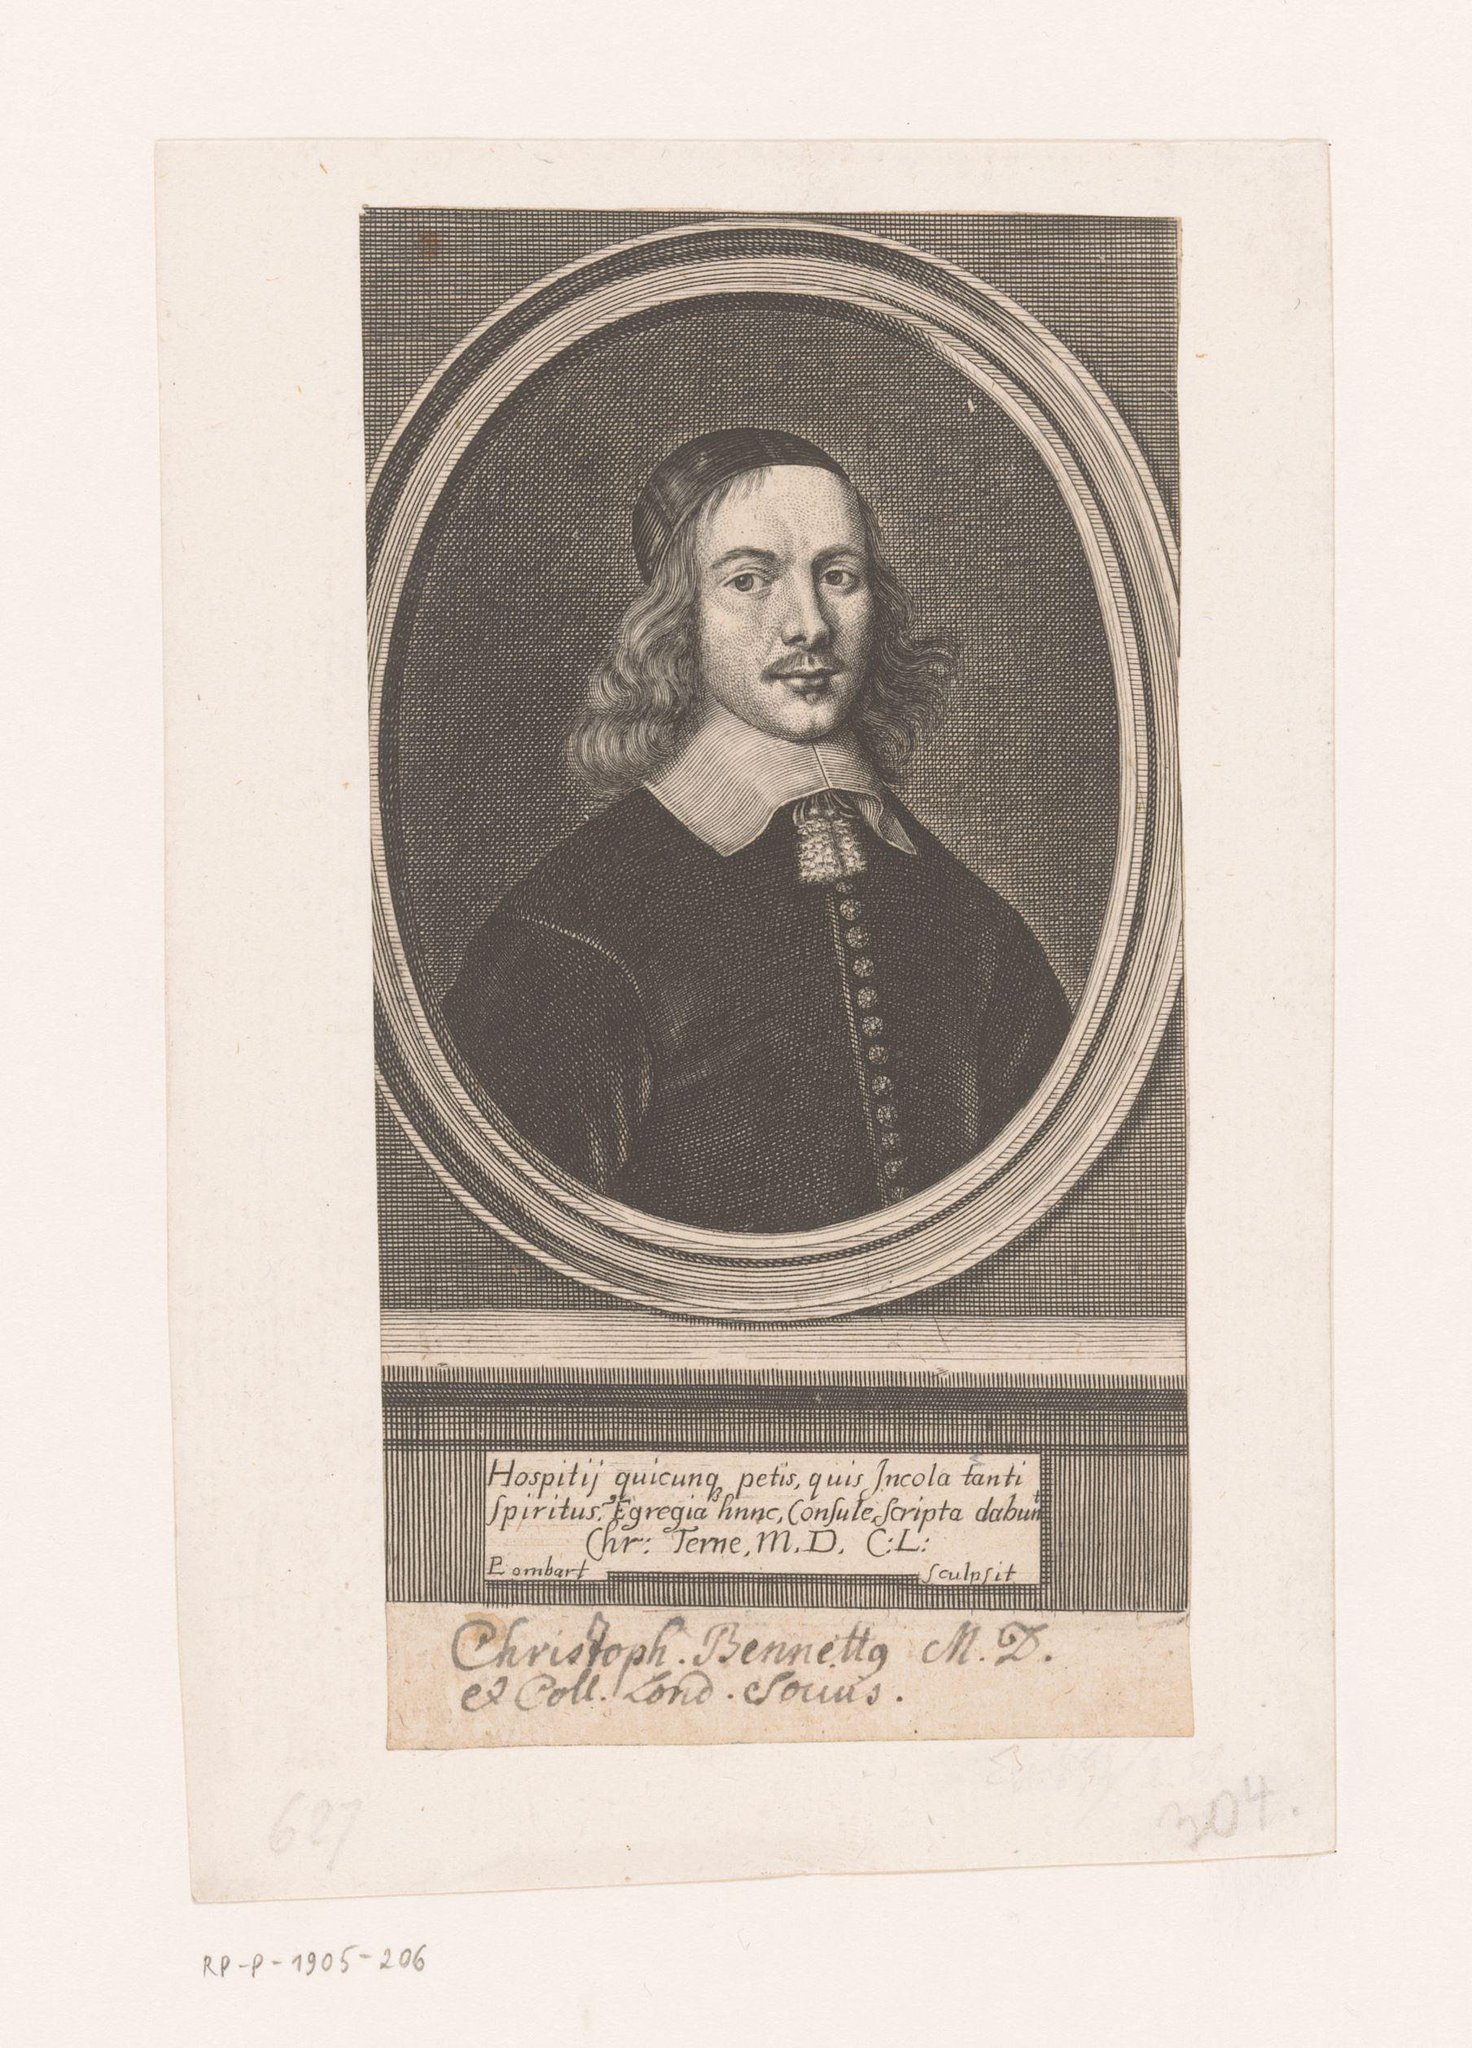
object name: print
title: Portret van Christopher Bennet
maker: pierre lombard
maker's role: draughtsman, print maker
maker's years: 1612-1682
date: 1650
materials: paper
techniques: engraving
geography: france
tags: historical persons, physician, doctor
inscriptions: inscription: ‘Christoph. Bennett, M.D. ex Coll. Lond. Sorius [?].’, collector's mark: Lugt 1337, collector's mark: Lugt 2228